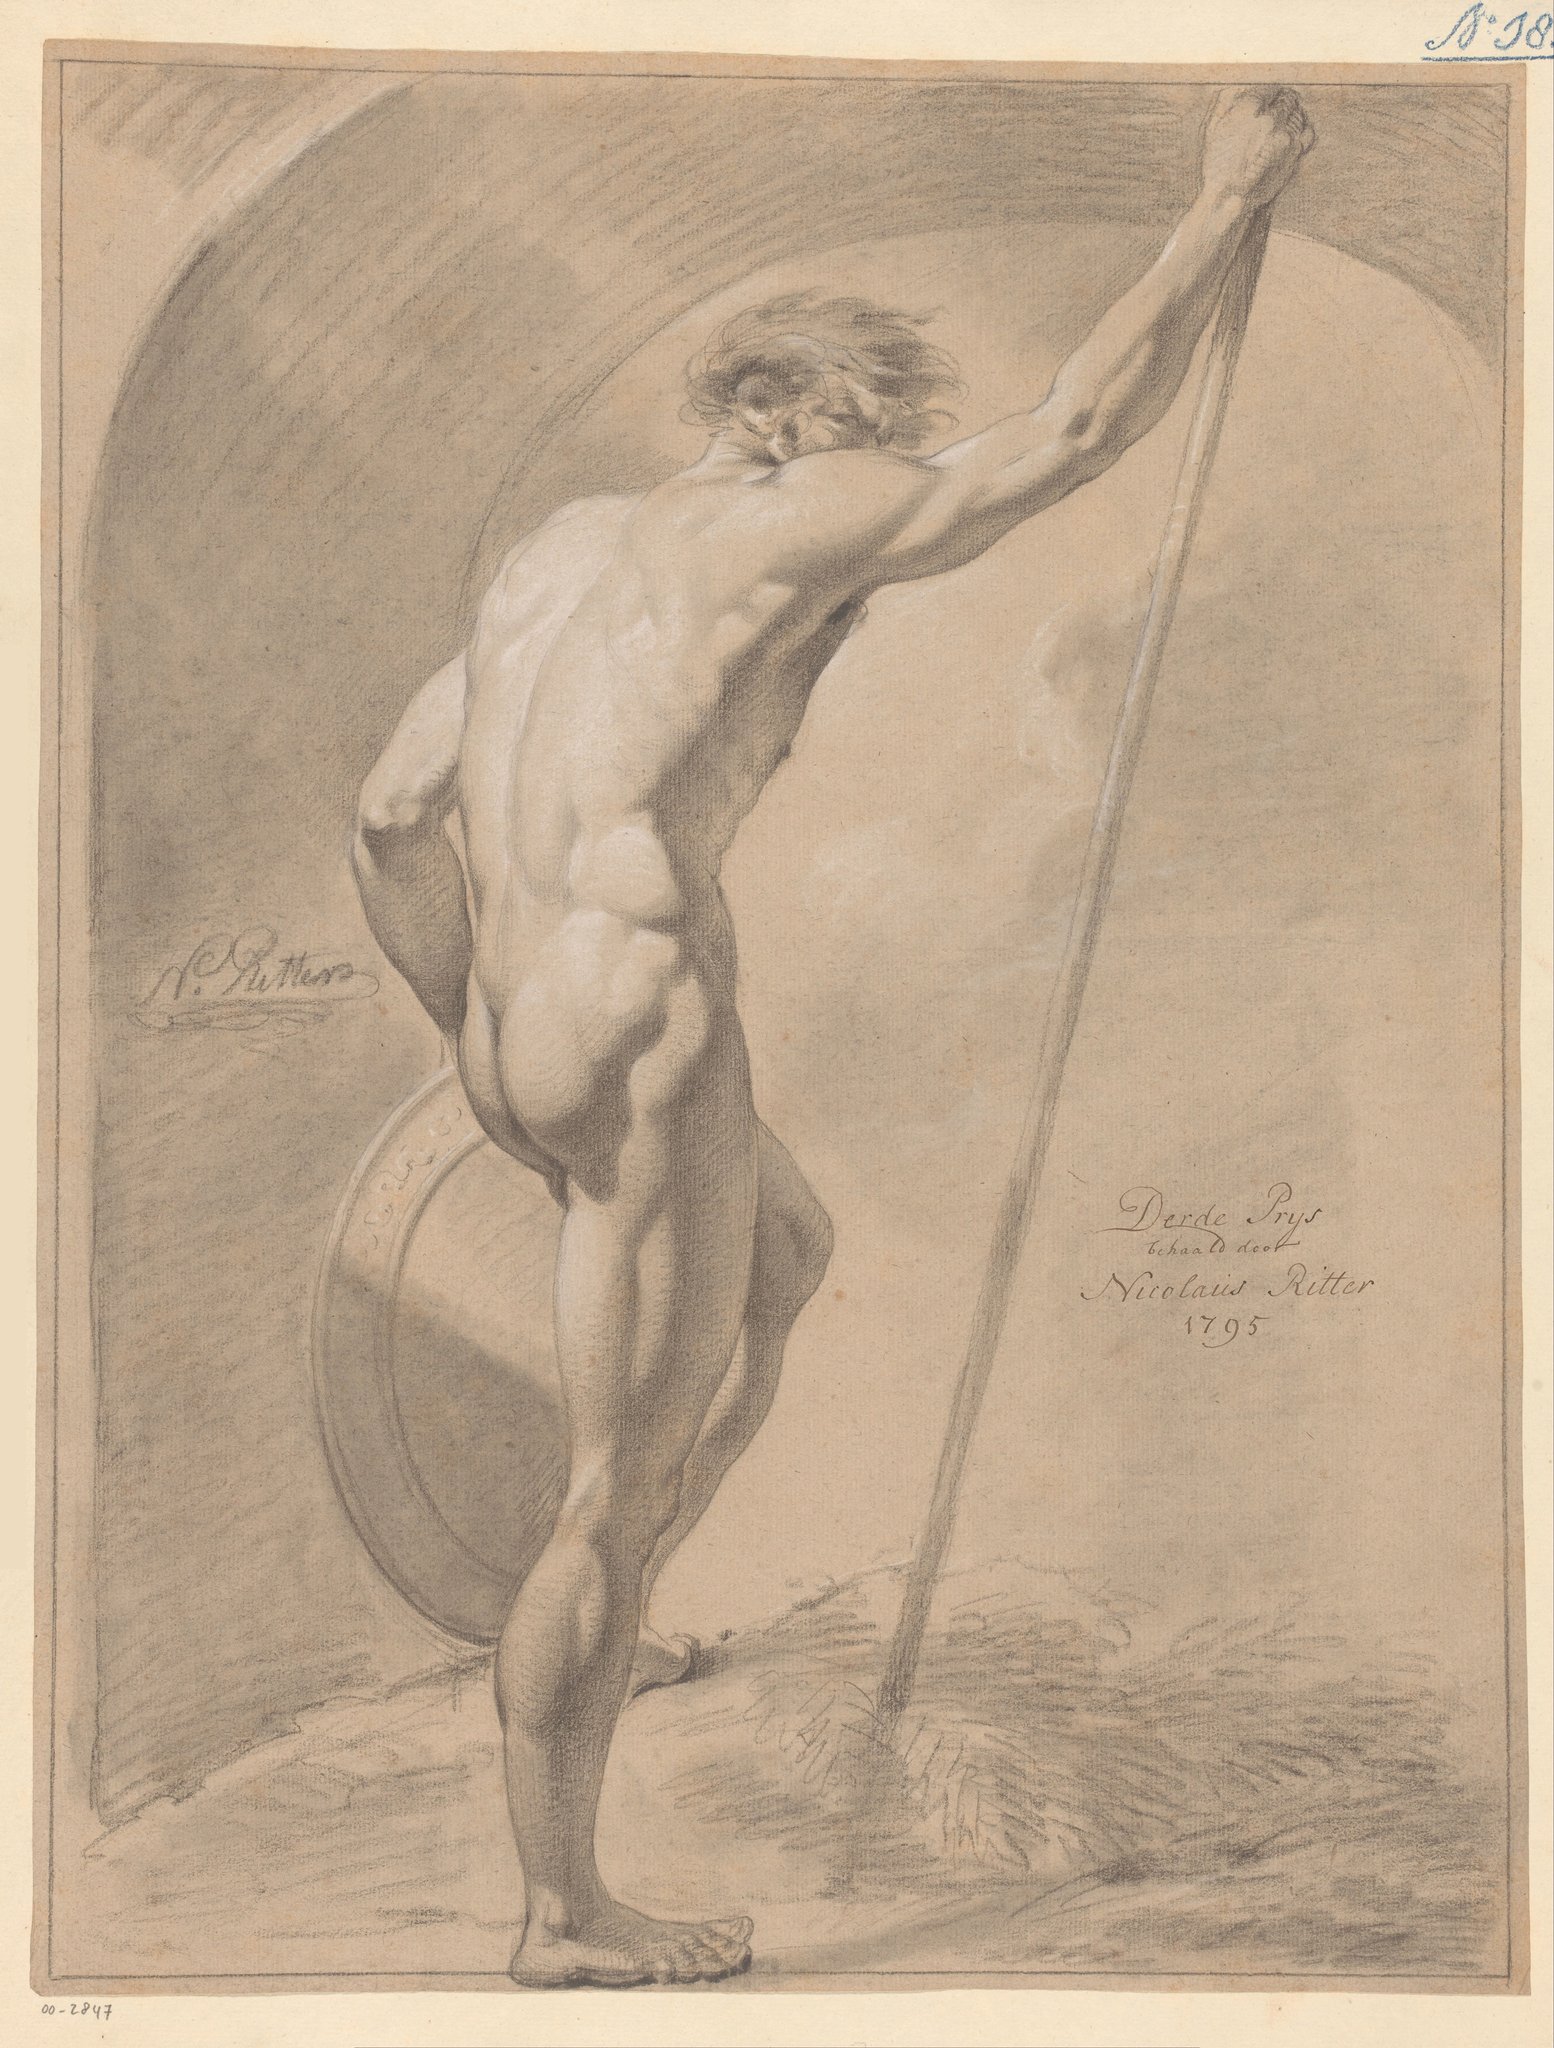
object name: drawing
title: Staand mannelijk naakt, op de rug gezien (3e prijs 1795)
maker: nicolaus ritter jr.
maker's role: draughtsman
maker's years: 1777-1797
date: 1795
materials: chalk, paper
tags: standing figure (+ nude human being)